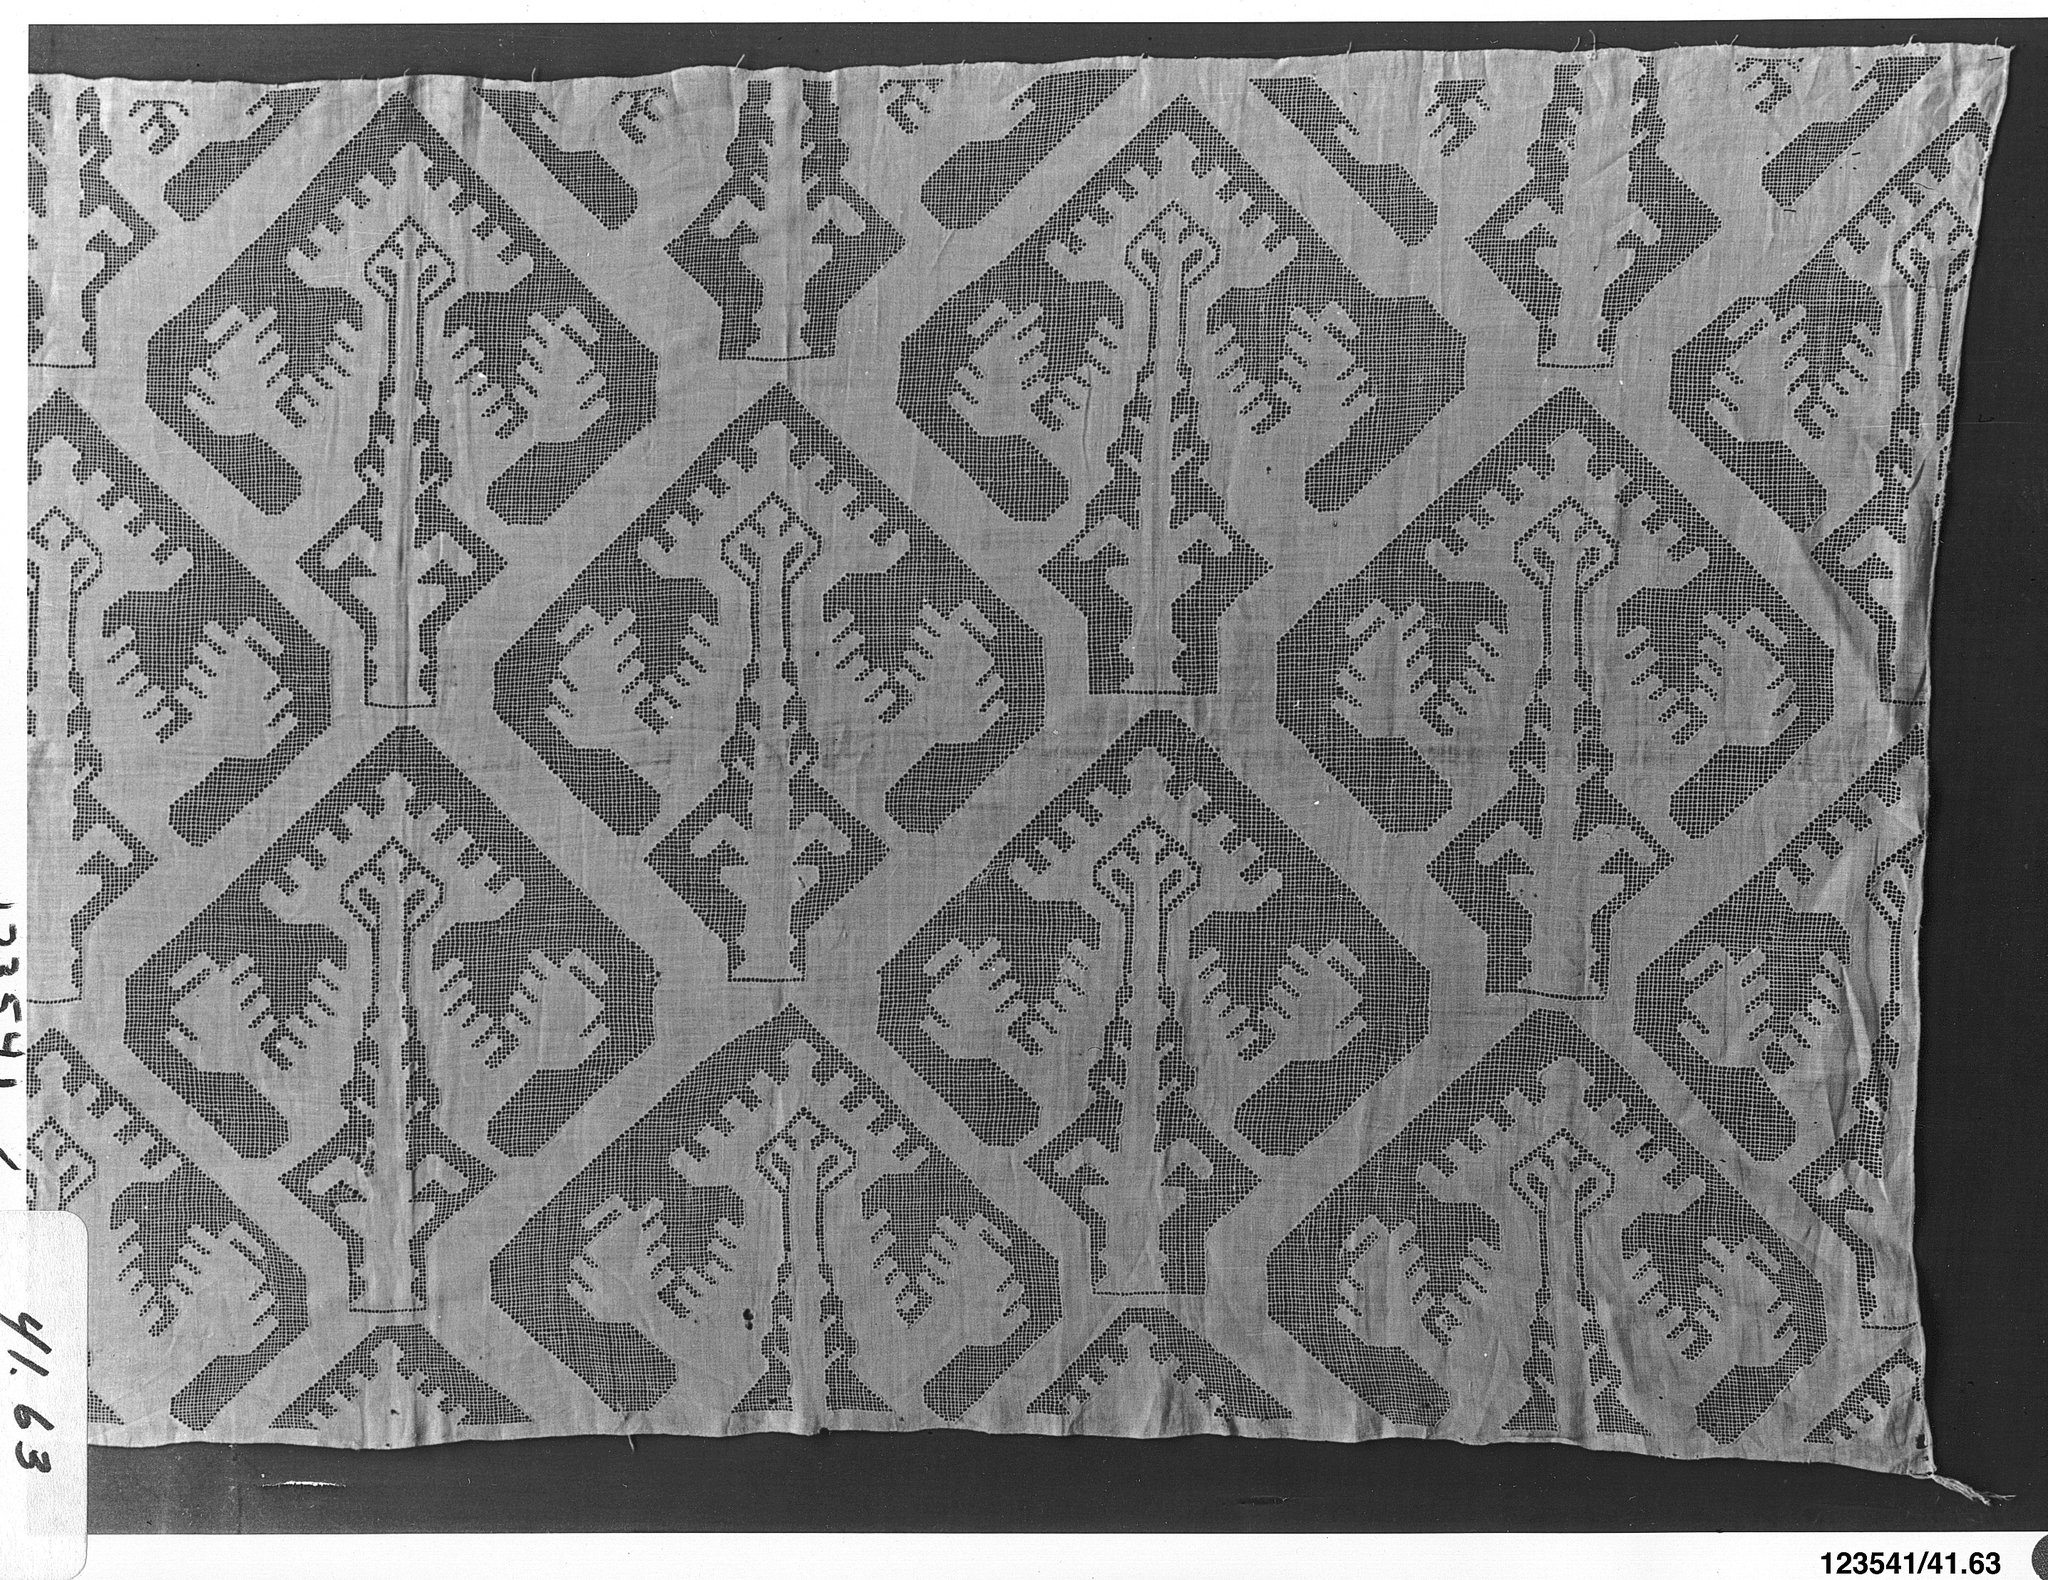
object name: altar frontal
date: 1601-1633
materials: linen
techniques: embroidery